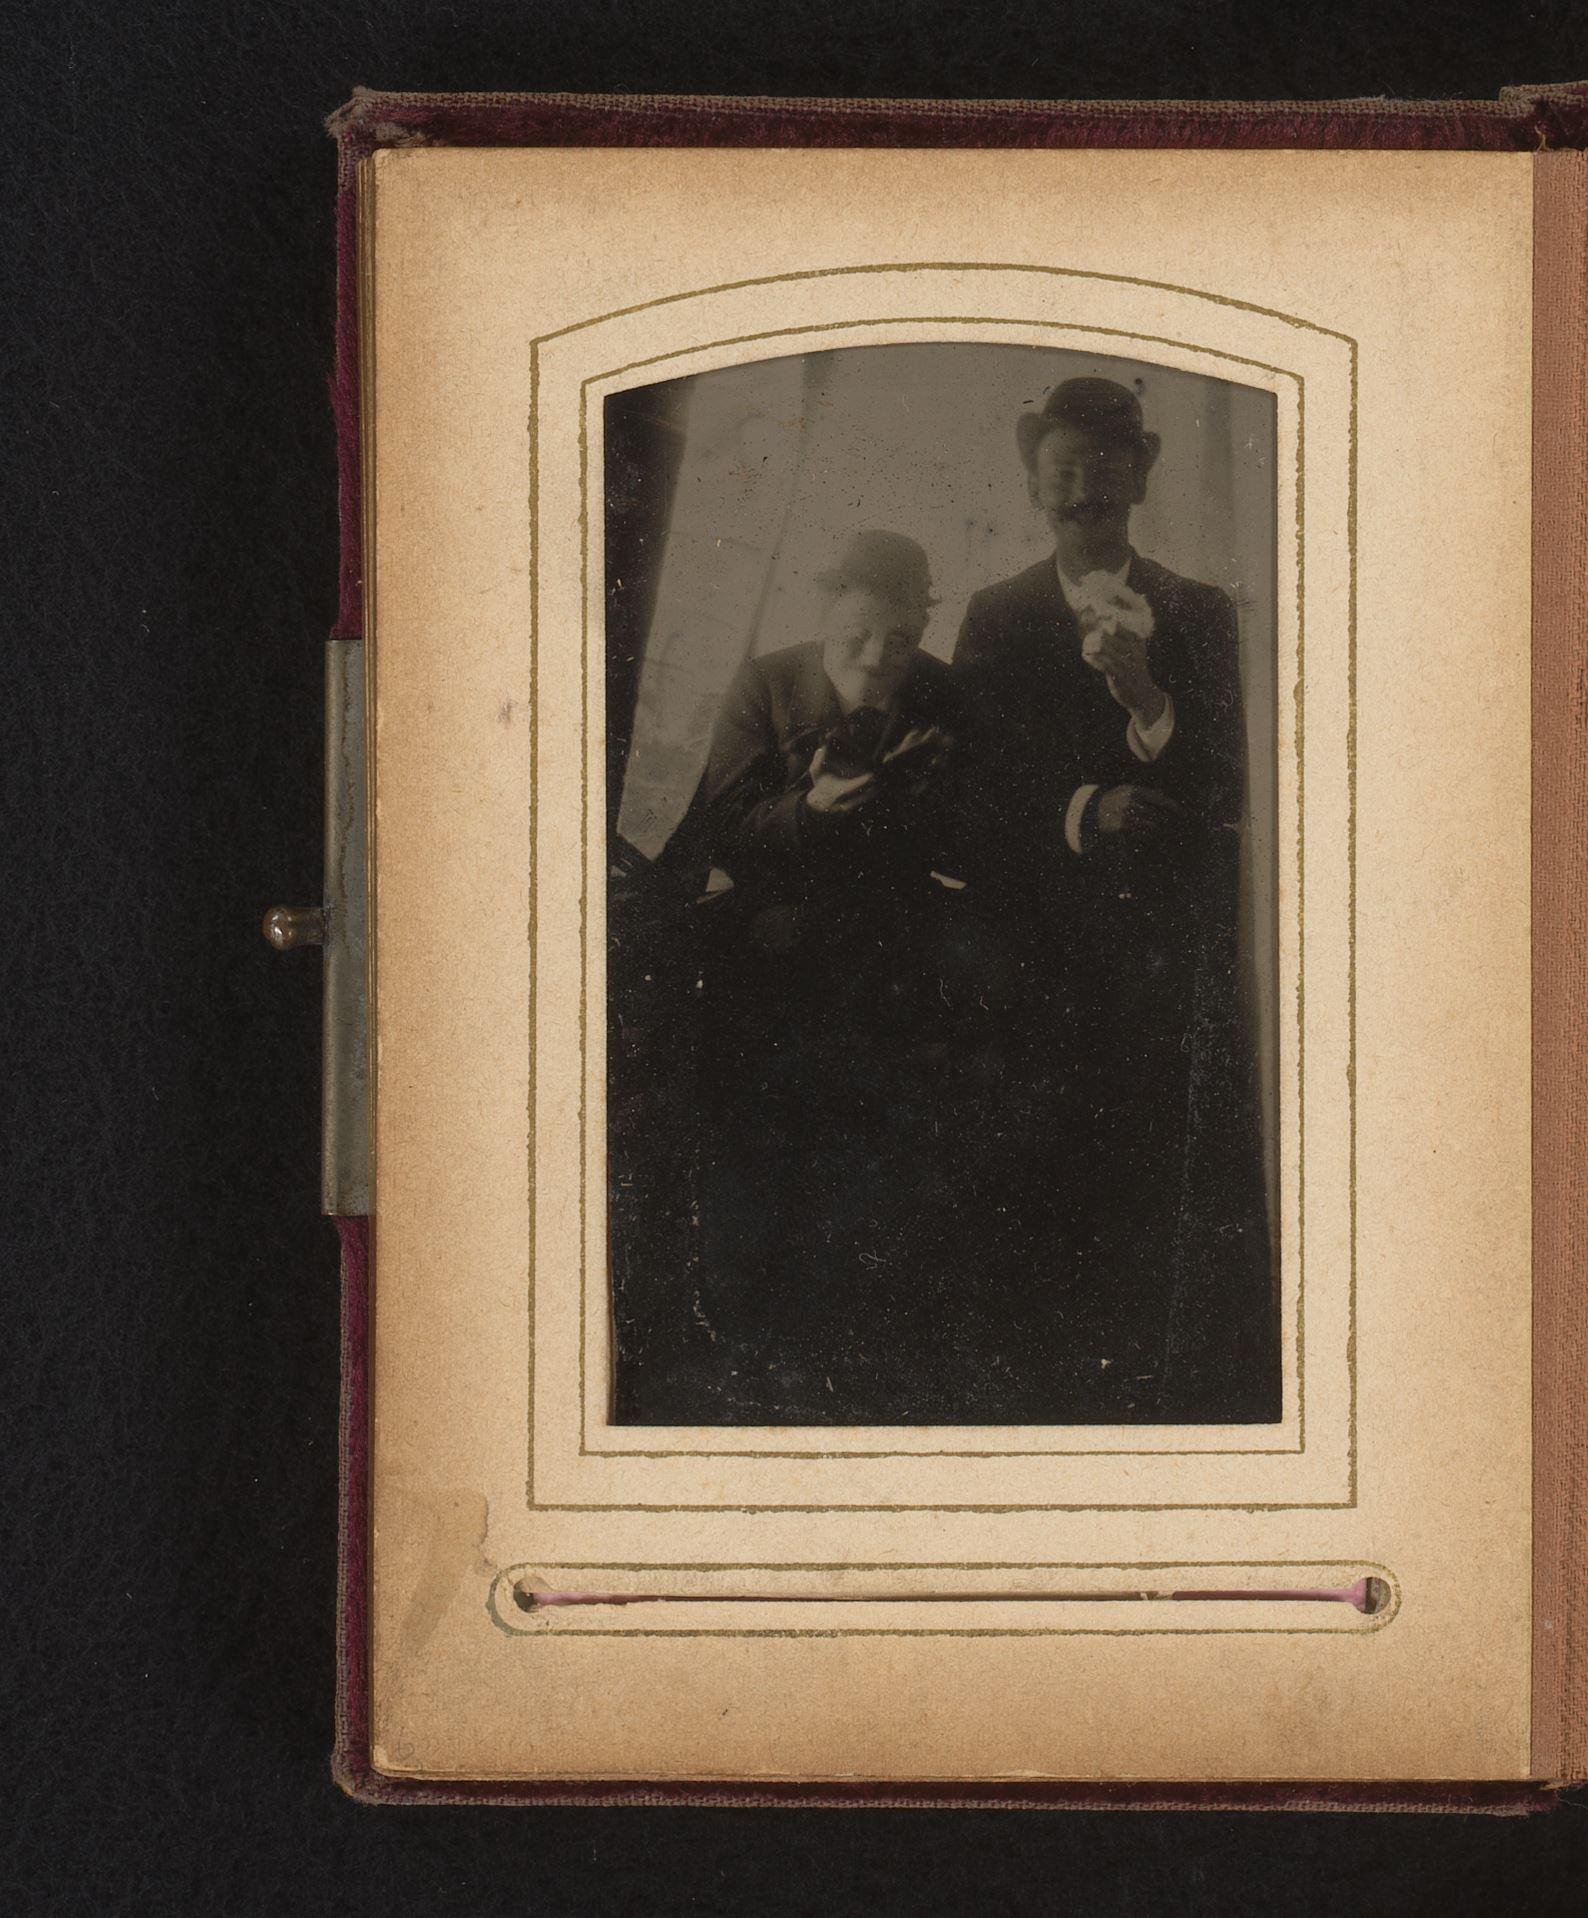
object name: album leaf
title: Portret van twee mannen met hoeden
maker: Anonymous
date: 1870-1882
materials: iron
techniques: ferrotyping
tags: head-gear, adult man, historical persons